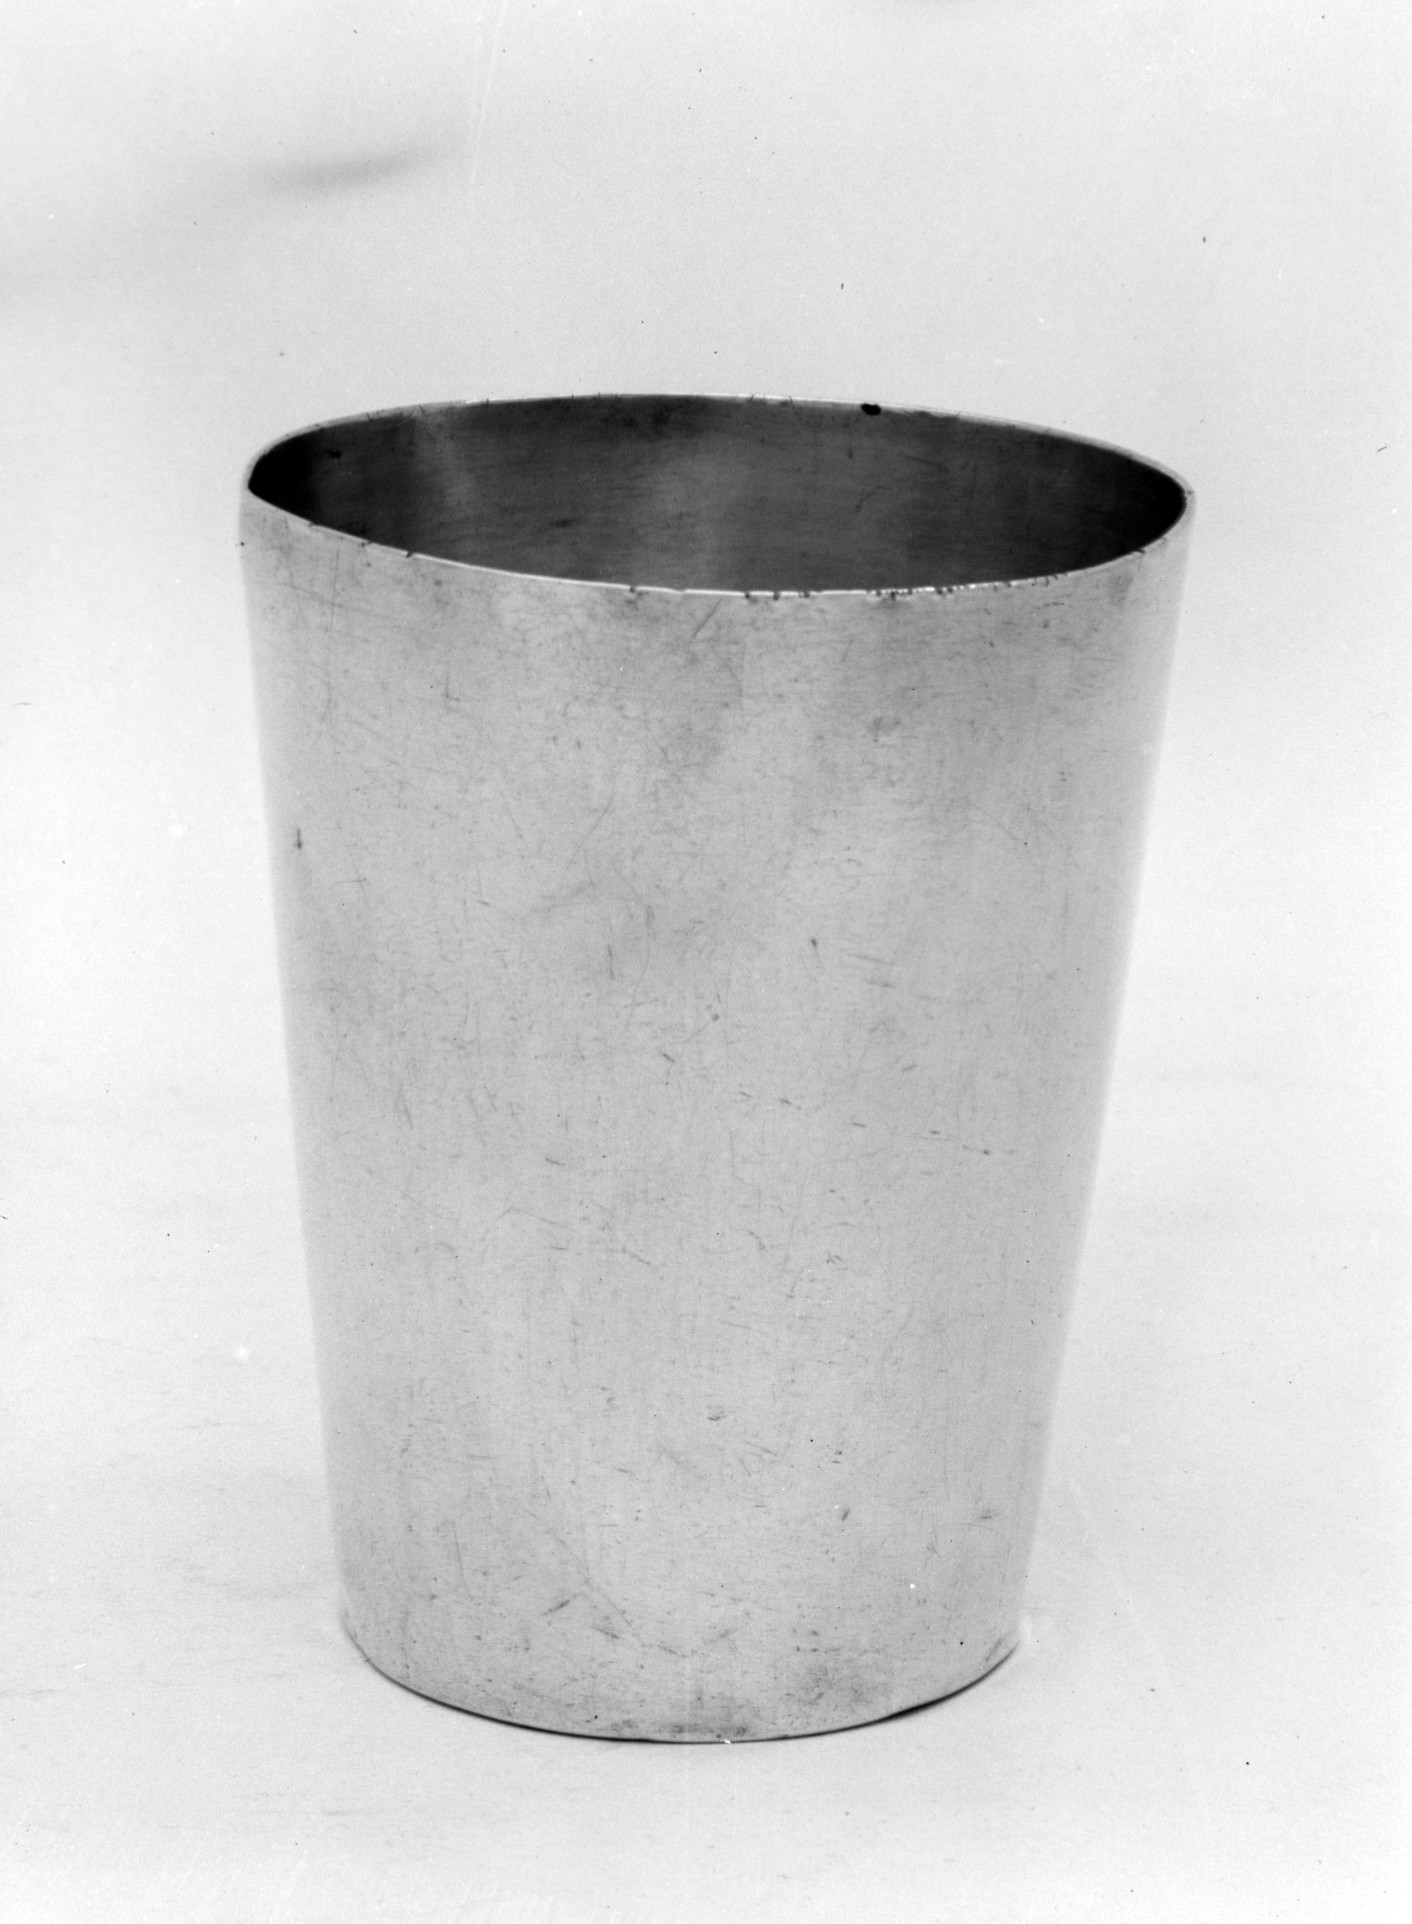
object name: beaker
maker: g. i. p.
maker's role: maker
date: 1767-1800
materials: silver